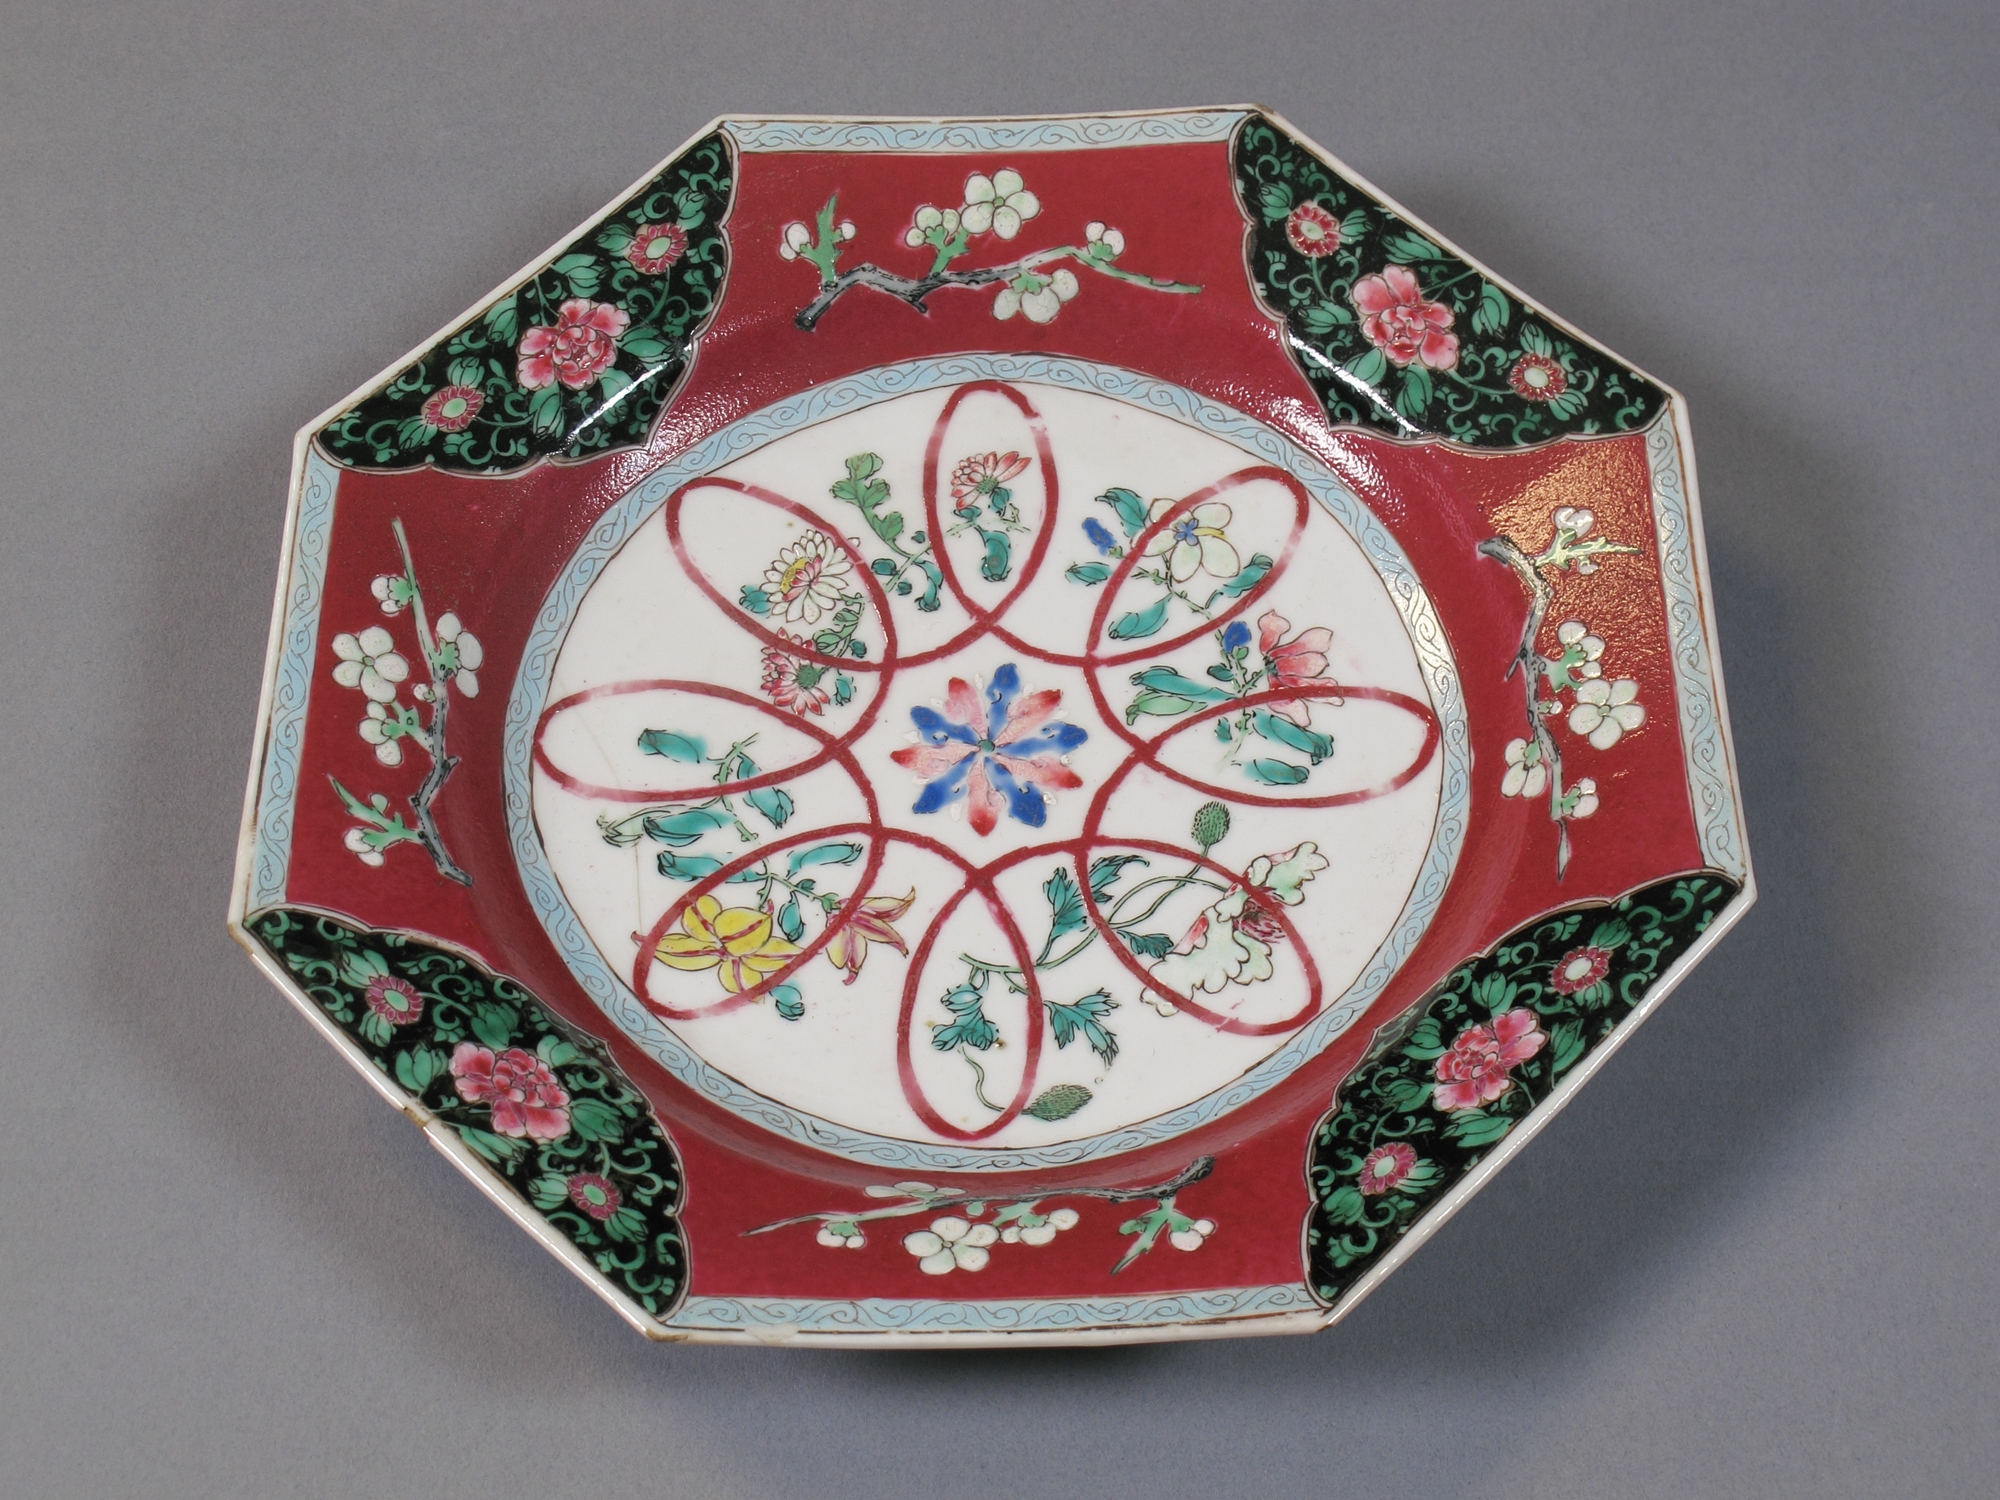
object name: dish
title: Octagonal dish with floral pattern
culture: chinese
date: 1767-1800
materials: enamel, porcelain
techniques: overglaze, painting, polychrome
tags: flowers